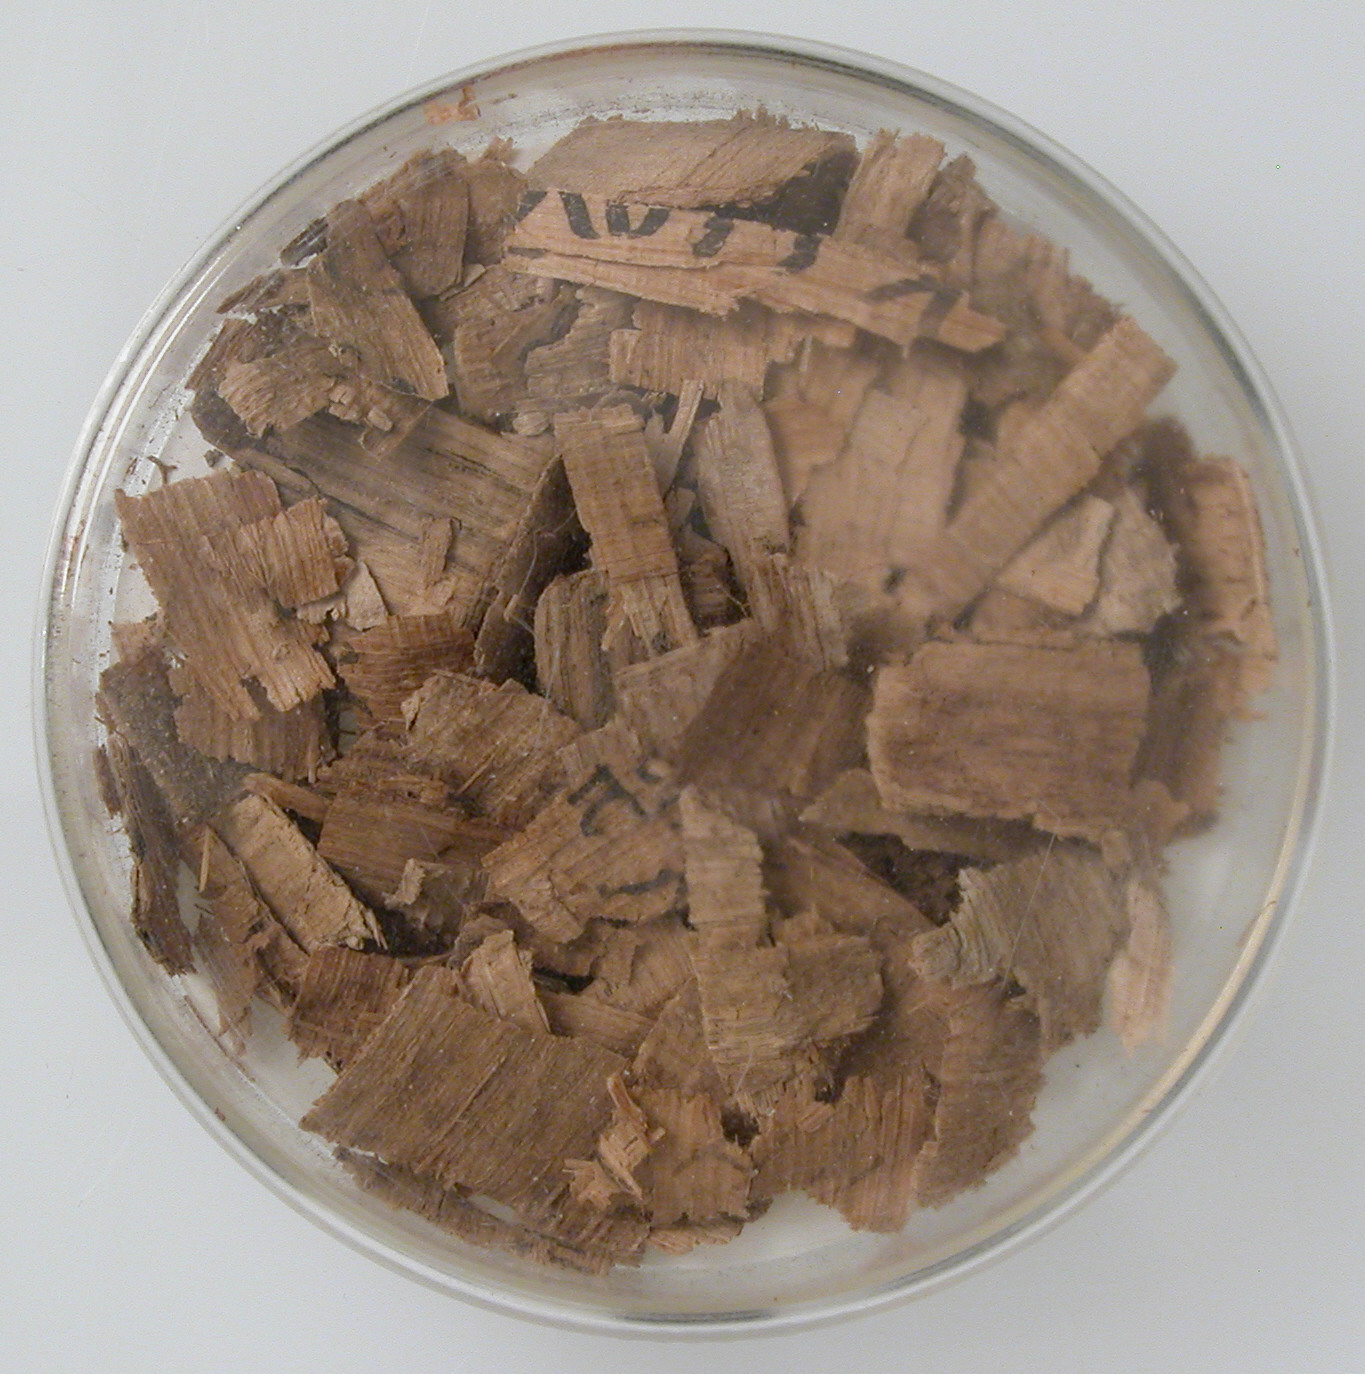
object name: fragment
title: Papyri Fragments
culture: coptic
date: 601-700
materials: ink, papyrus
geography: egypt